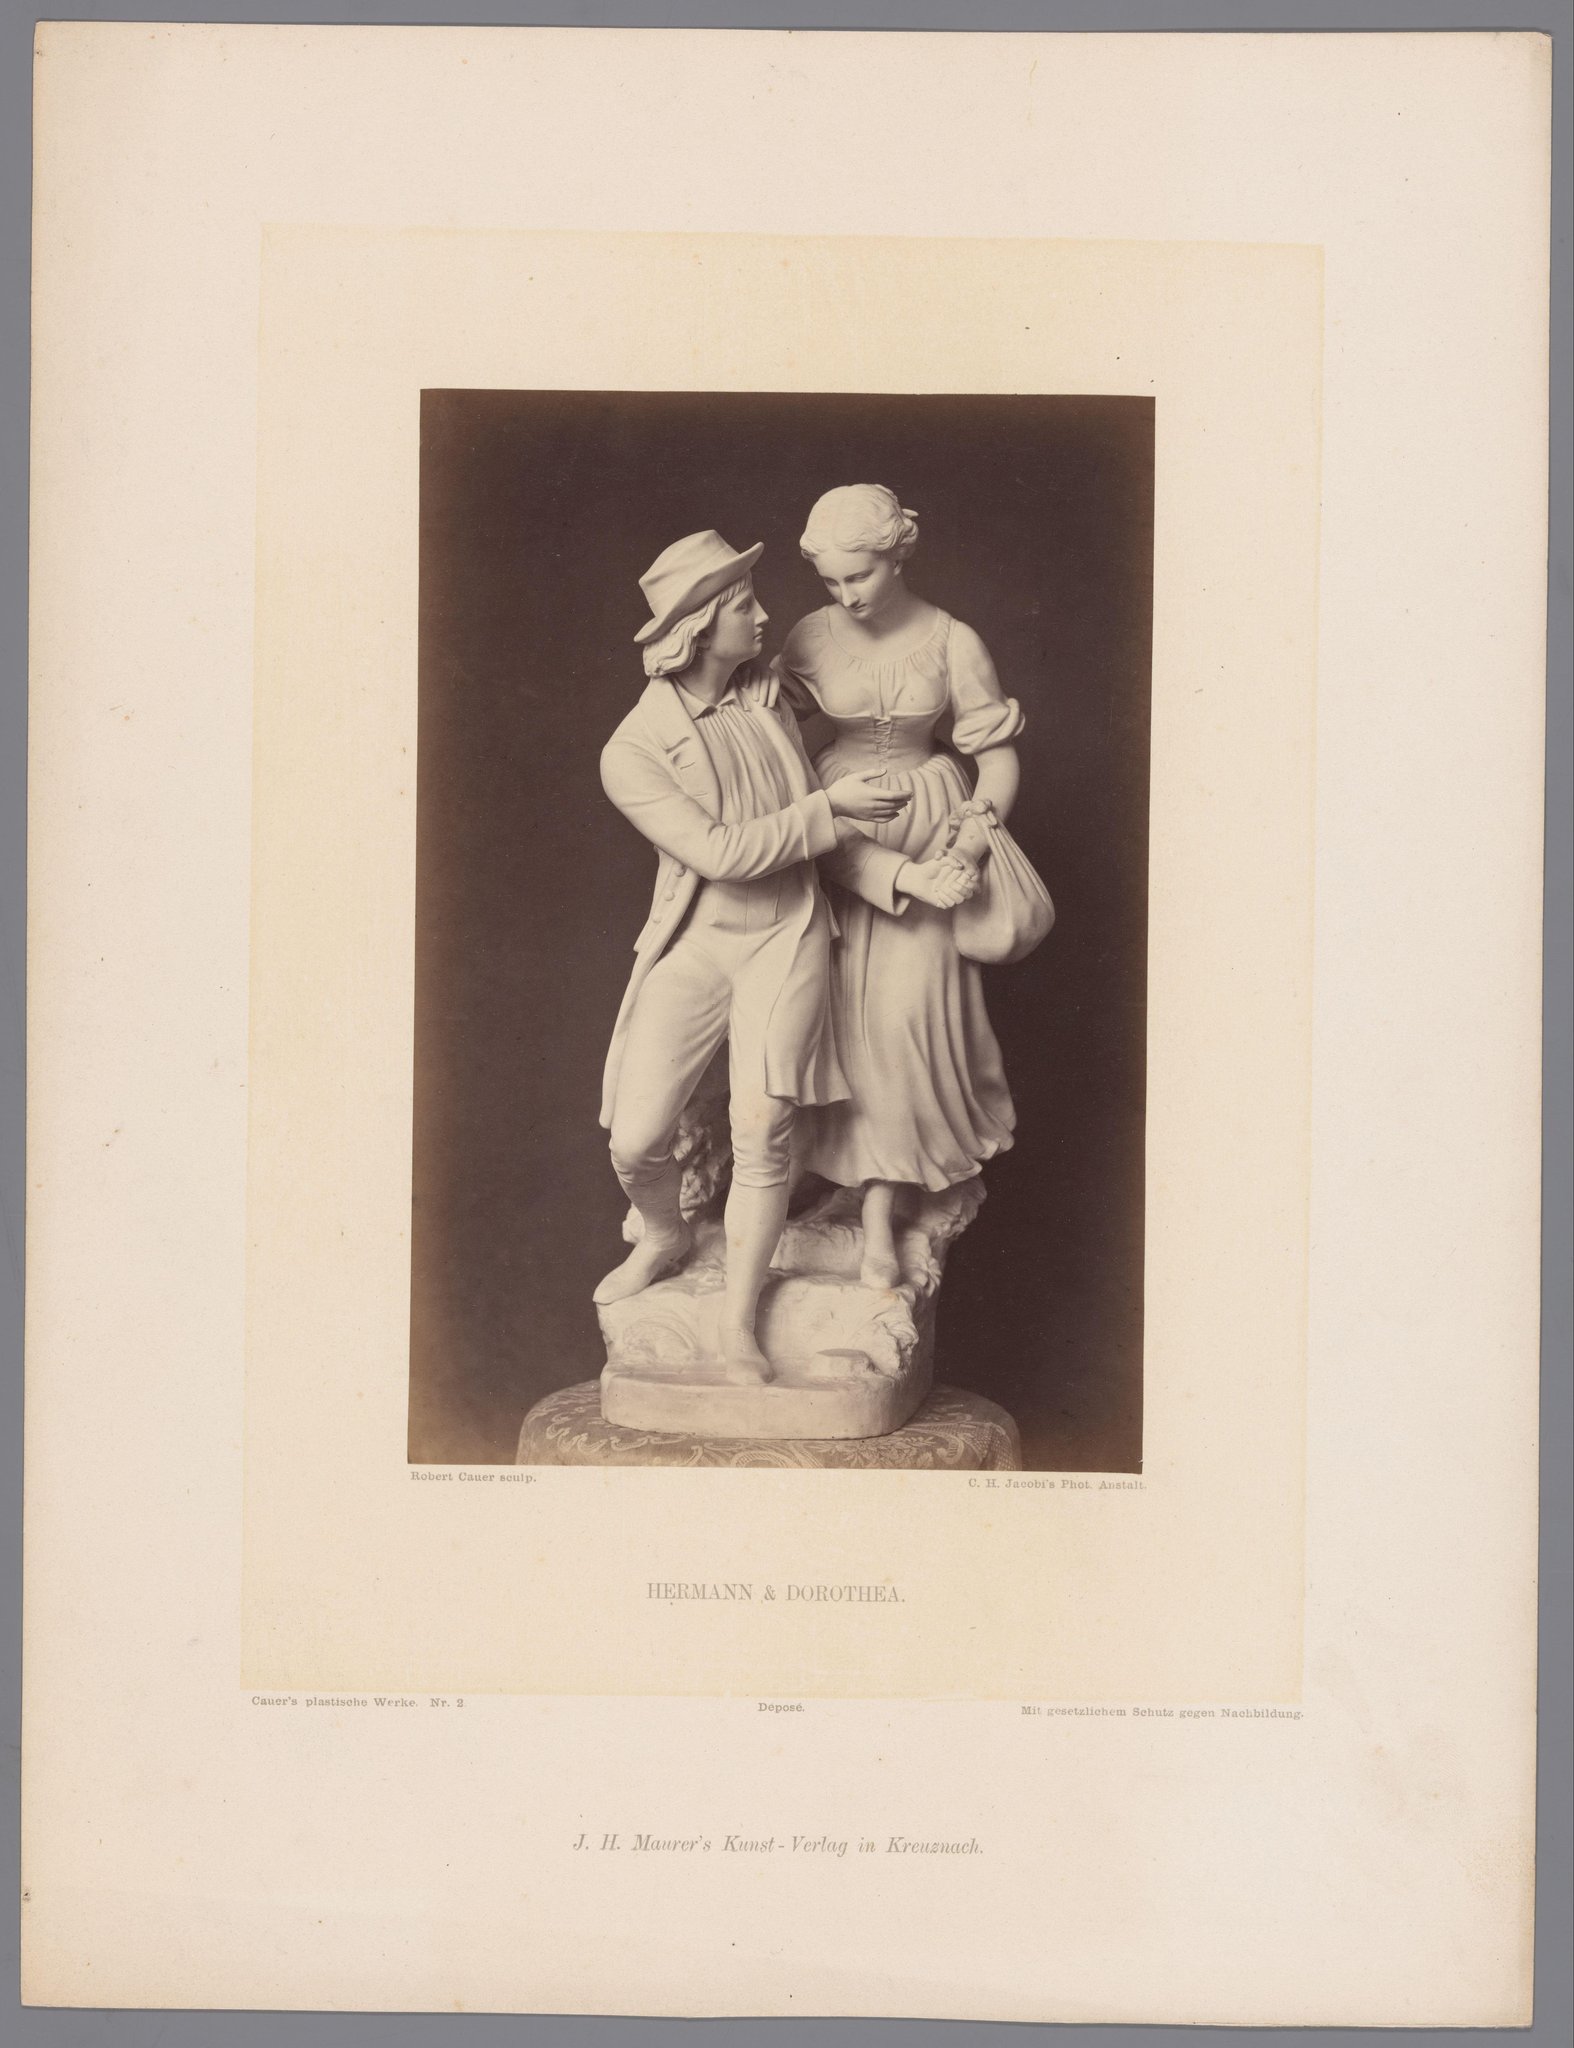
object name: photograph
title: Hermann en Dorothea door Robert Cauer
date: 1850-1900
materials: cardboard, photographic support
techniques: albumen print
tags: adult woman, adult man, sculpture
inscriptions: inscription: ‘Robert Cauer sculp./Cauer's plastische Werke. Nr. 2 Déposé. Mit gesetzlichem Schutz gegen Nachbildung’